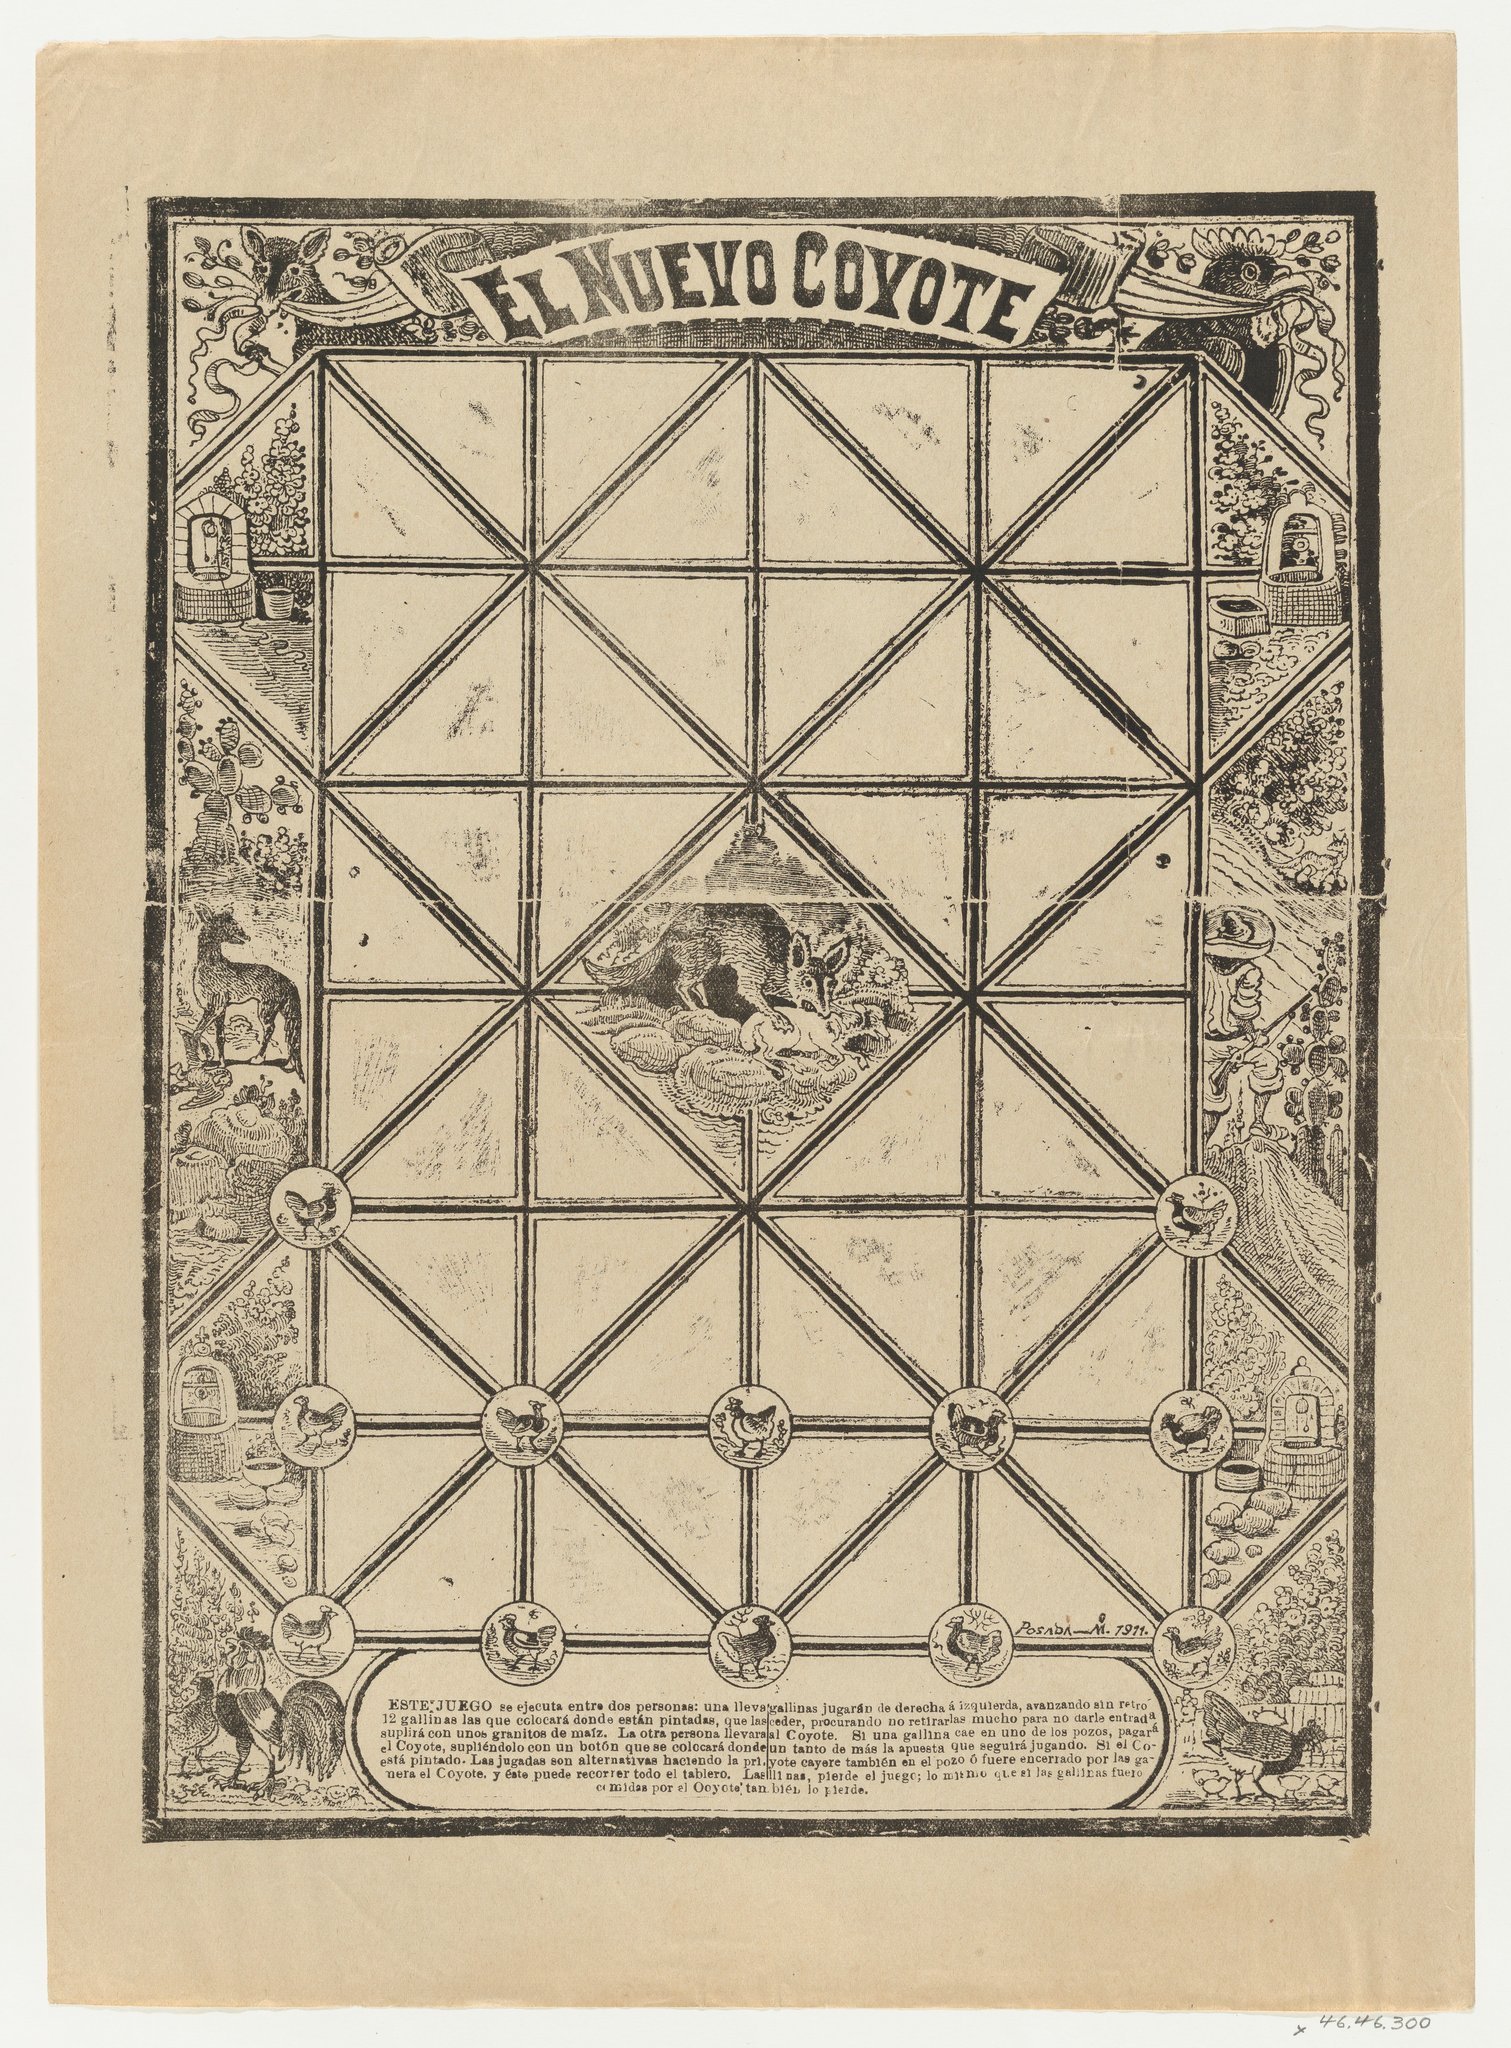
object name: print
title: Game of the Coyote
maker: josé guadalupe posada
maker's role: artist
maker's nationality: mexican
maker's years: 1852-1913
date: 1911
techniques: letterpress, lithography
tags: animals,roosters